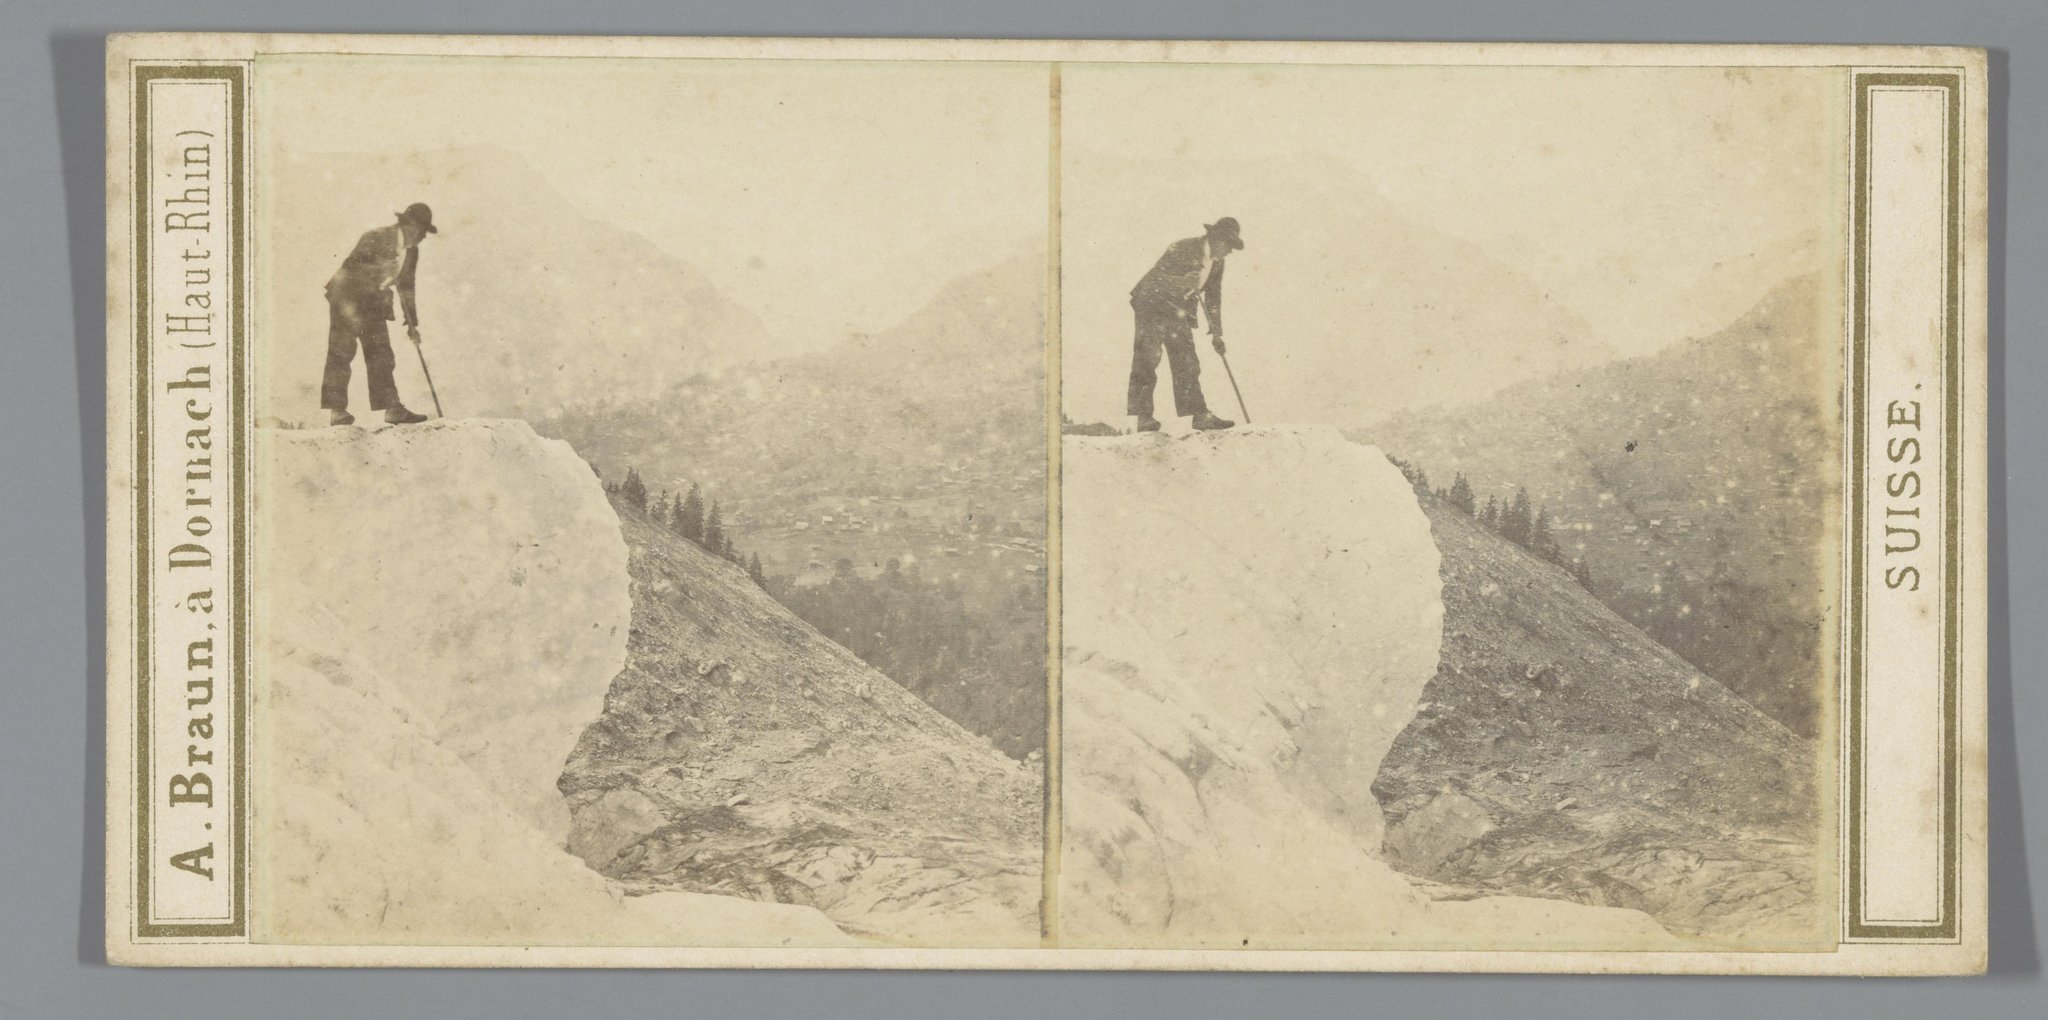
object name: stereograph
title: Oberland Bernois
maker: Anonymous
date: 1860-1866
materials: cardboard, paper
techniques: albumen print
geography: dornach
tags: obere grindelwaldgletsjer, grindelwald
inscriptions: number: ‘No 3286.’